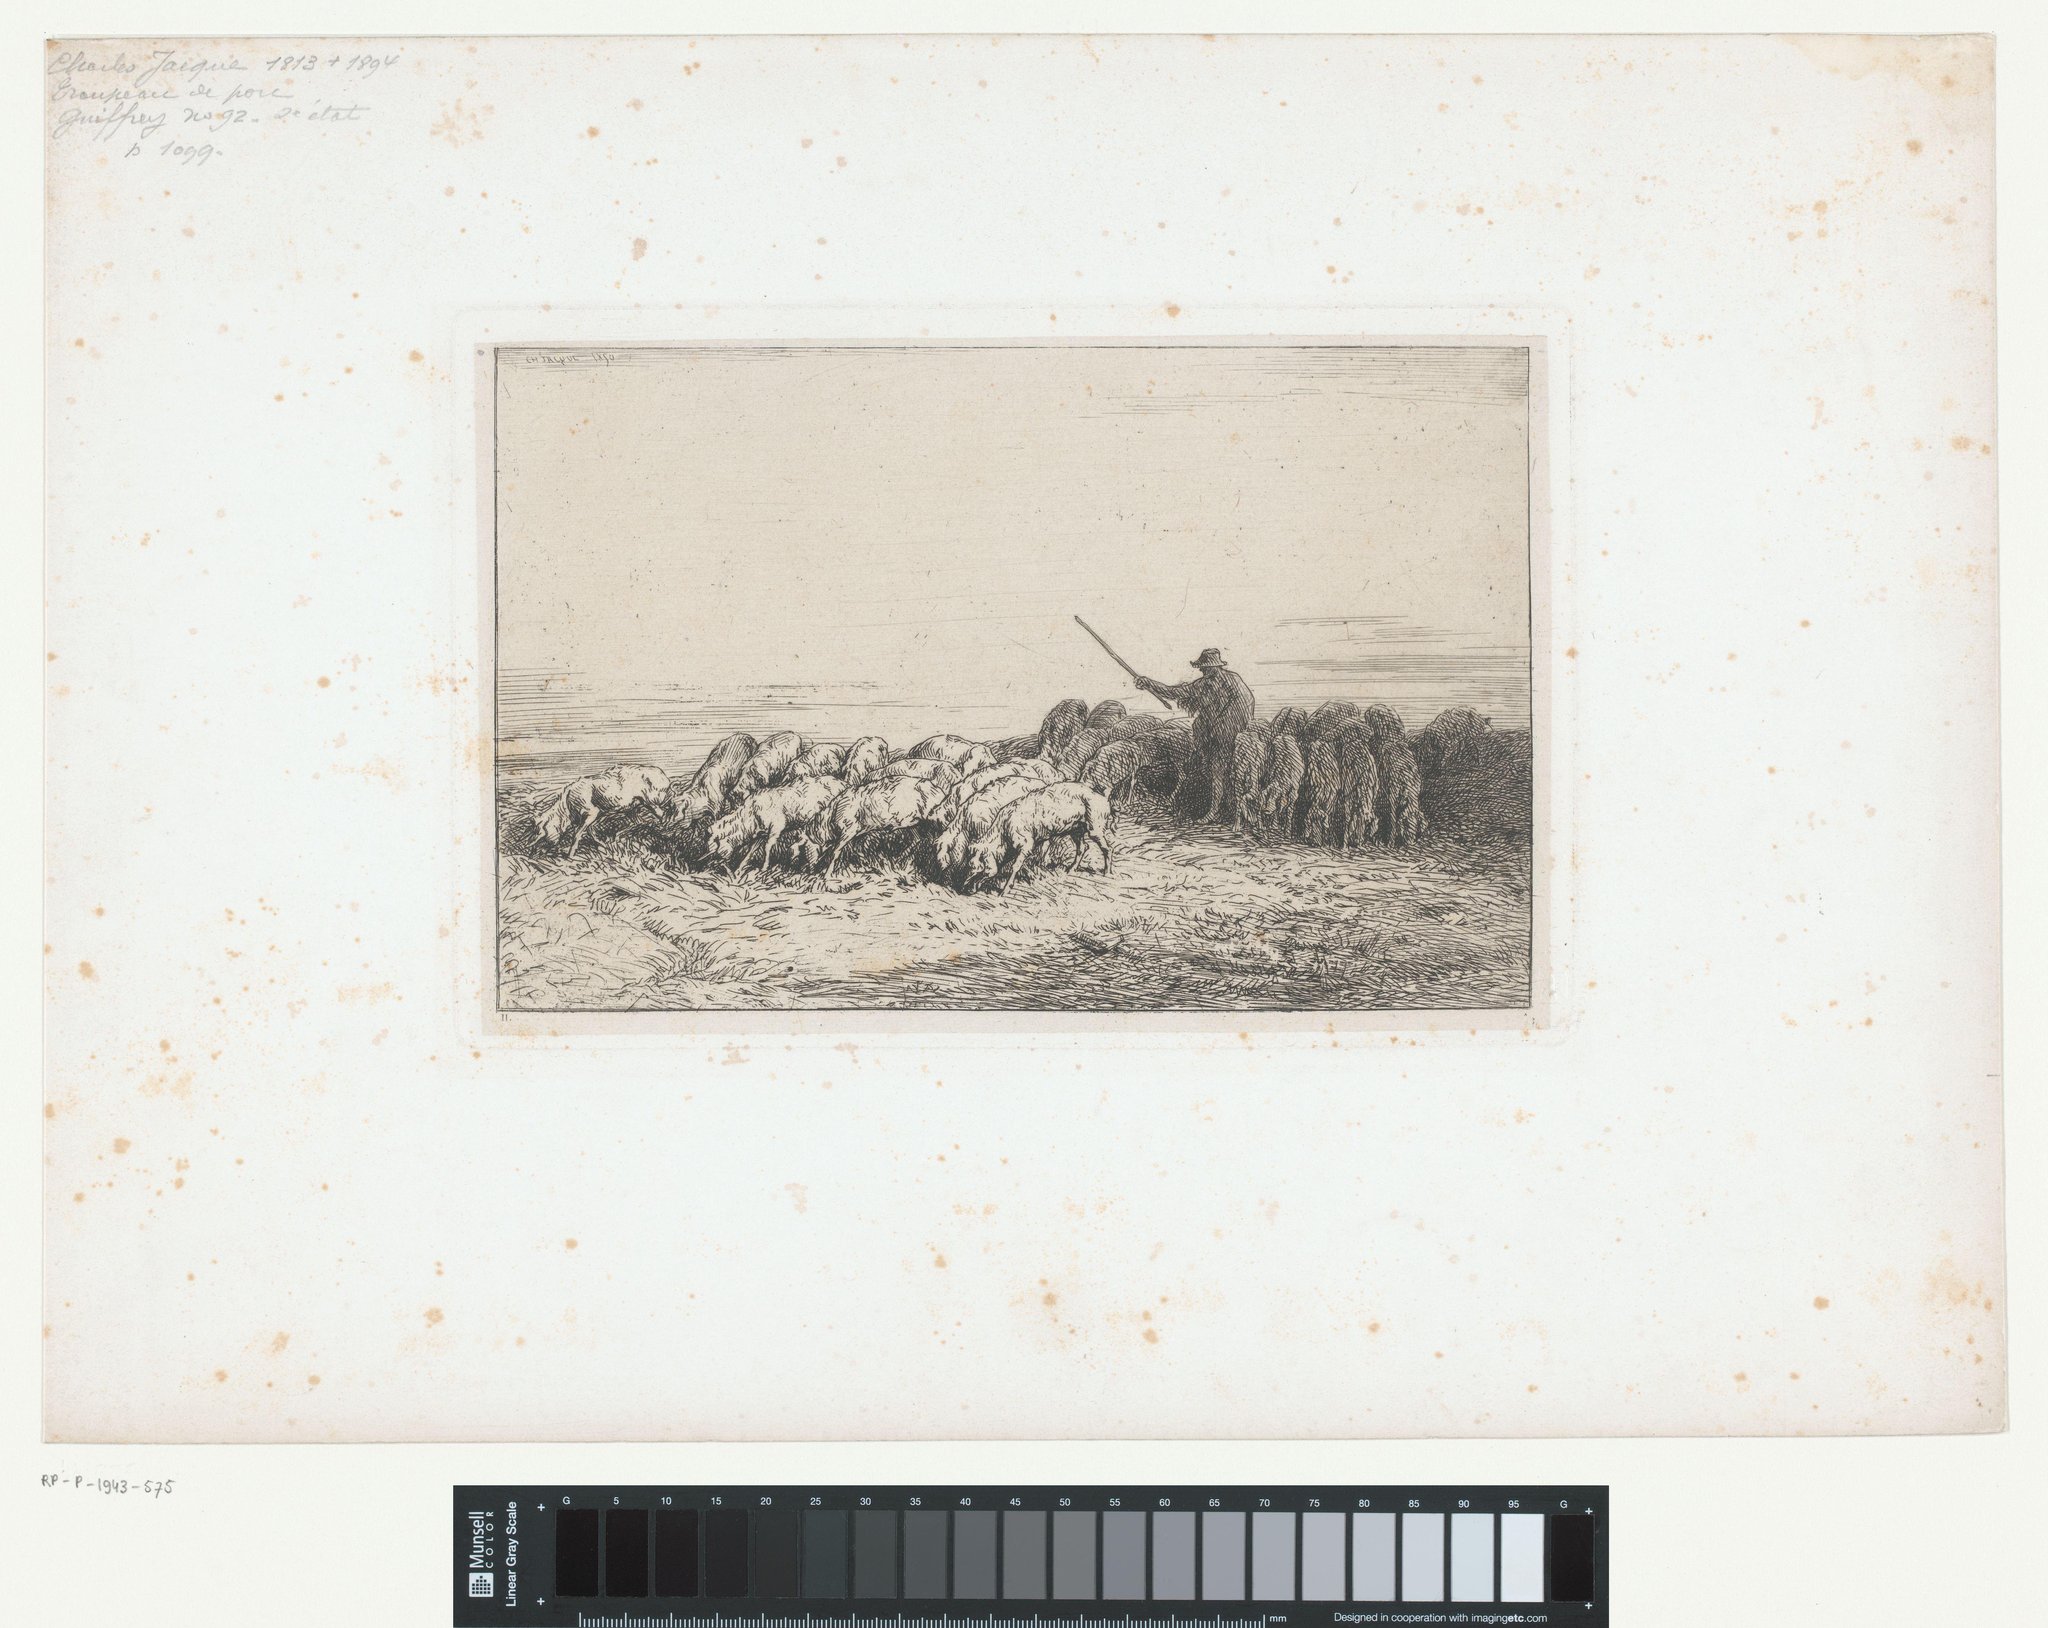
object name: print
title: 20 sujets composés et gravés à l'eau-forte par Ch. Jacque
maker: charles emile jacque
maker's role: draughtsman, painter, print maker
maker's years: 1813-1894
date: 1850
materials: paper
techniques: etching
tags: pig, occupations ~ cattle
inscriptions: collector's mark: Lugt 2228, check stamp: Lugt 1816d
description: Maakt deel uit van een twintigdelige serie met verschillende onderwerpen door Jacque.